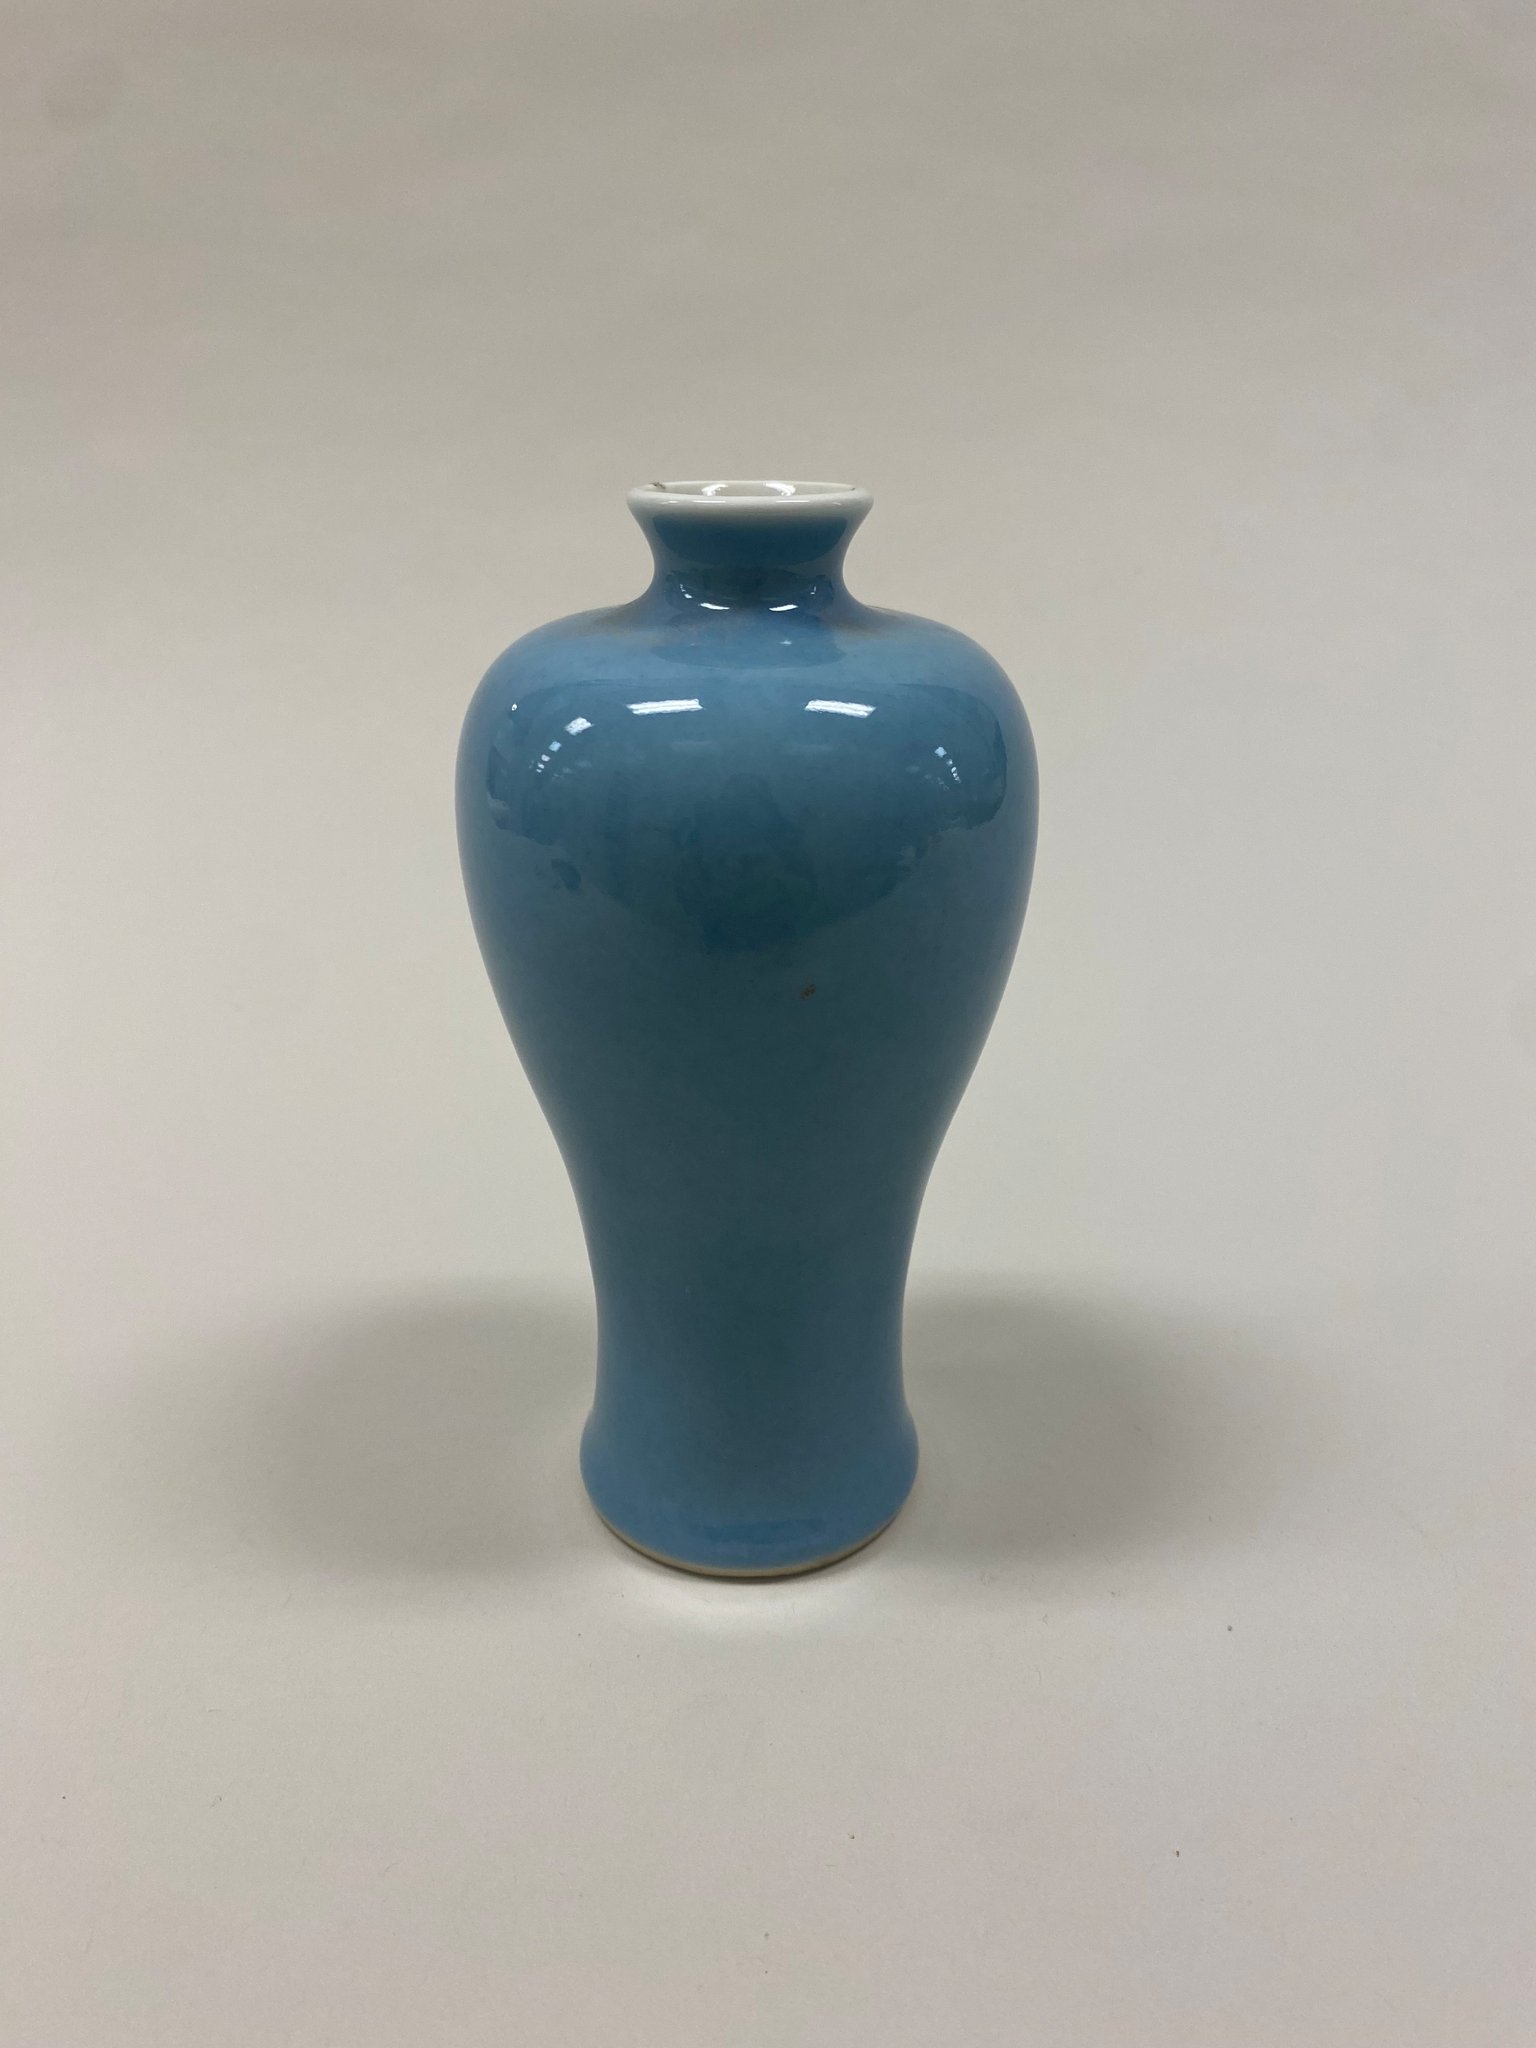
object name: vase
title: Meiping vase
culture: chinese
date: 1801-1900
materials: glaze, porcelain